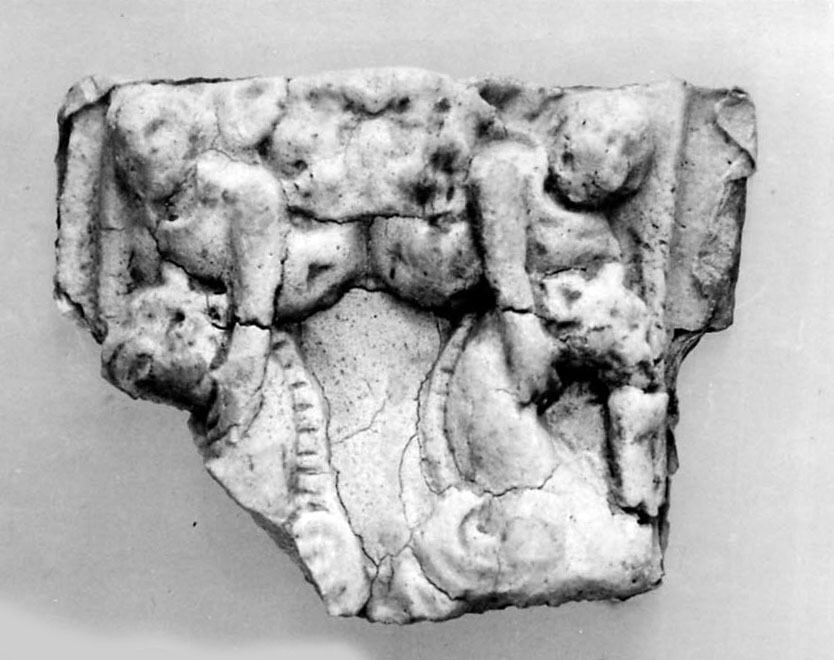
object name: relief fragment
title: Fragment of a Relief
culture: central asian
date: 201-700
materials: plaster